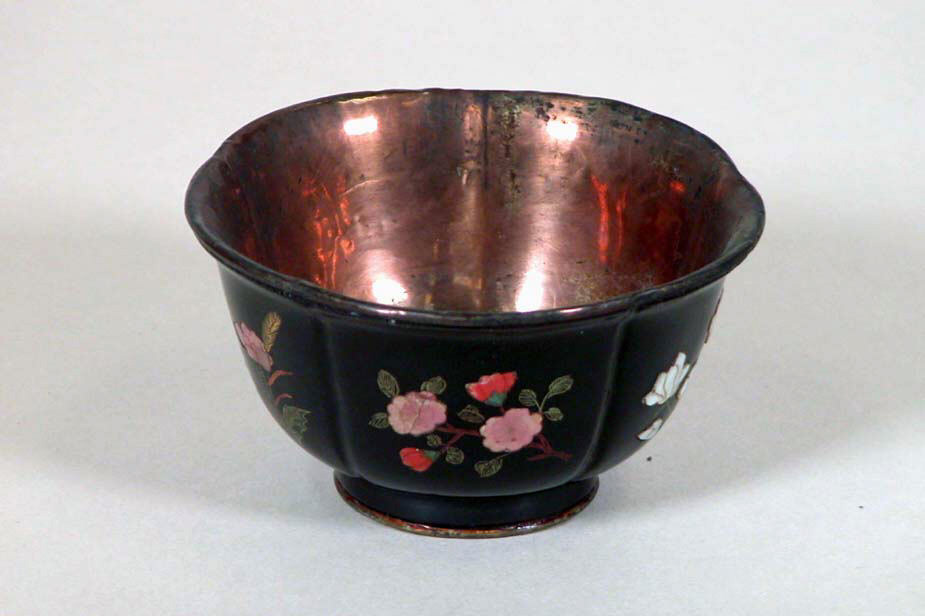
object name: bowl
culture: chinese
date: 1701-1800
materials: lacquer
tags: leaves